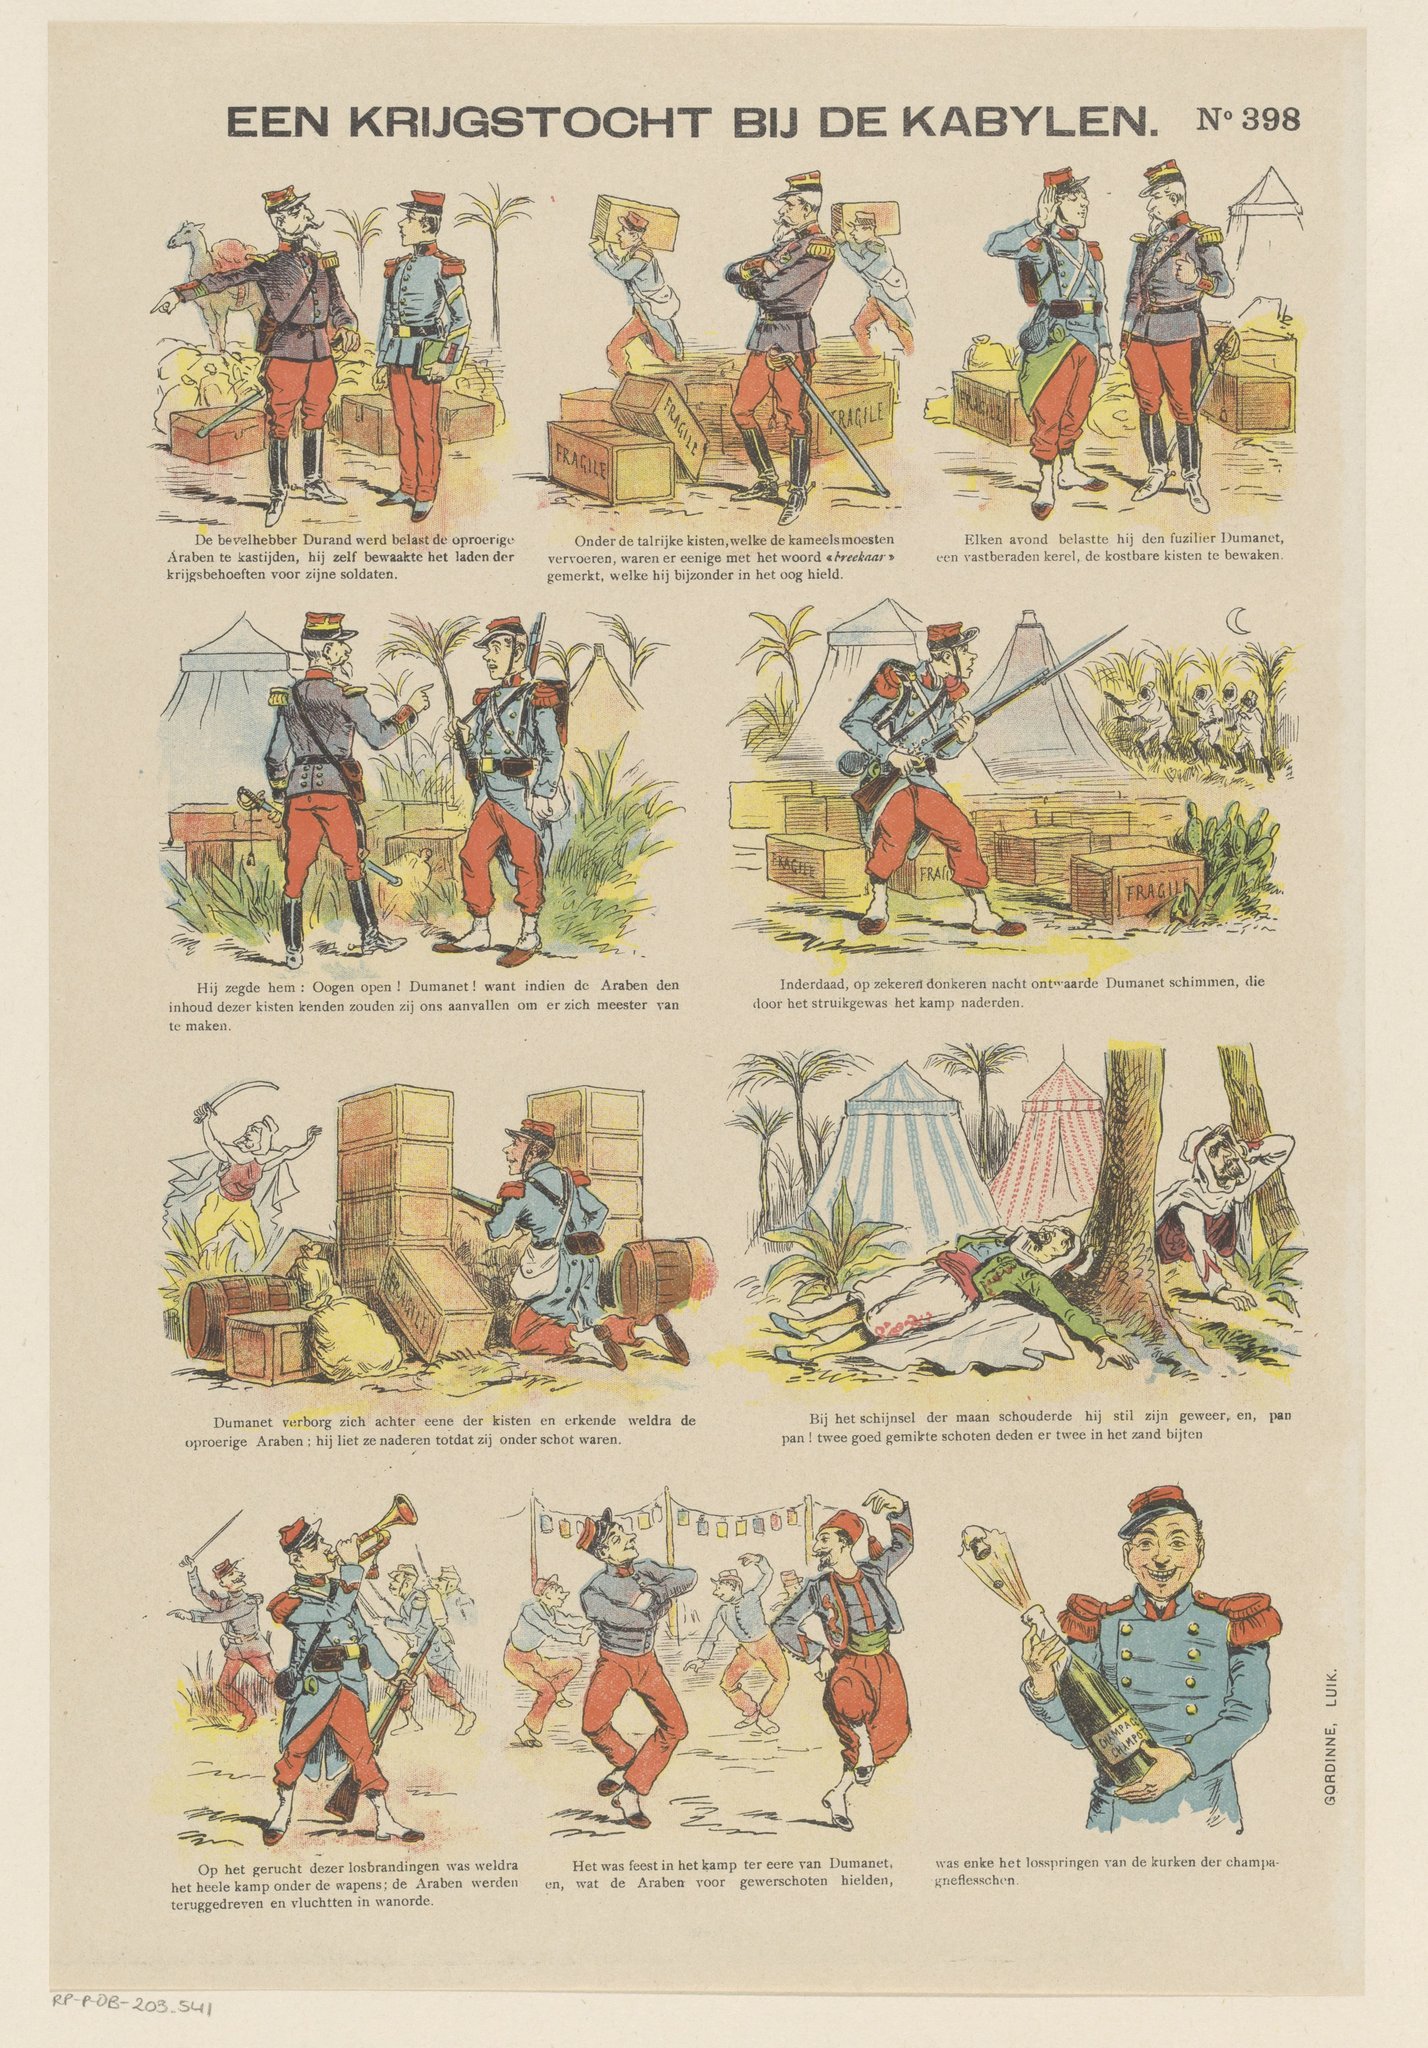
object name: popular print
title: Een krijgstocht bij de Kabylen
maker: Anonymous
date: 1894-1959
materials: paper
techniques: lithograph, letterpress printing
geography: liège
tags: the soldier; the soldier's life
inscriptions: collector's mark: Lugt 2760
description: Blad met 10 voorstellingen over fuselier Dumanet die een partij kisten moet bewaken. Onder elke afbeelding een onderschrift. Genummerd rechtsboven: No 398.